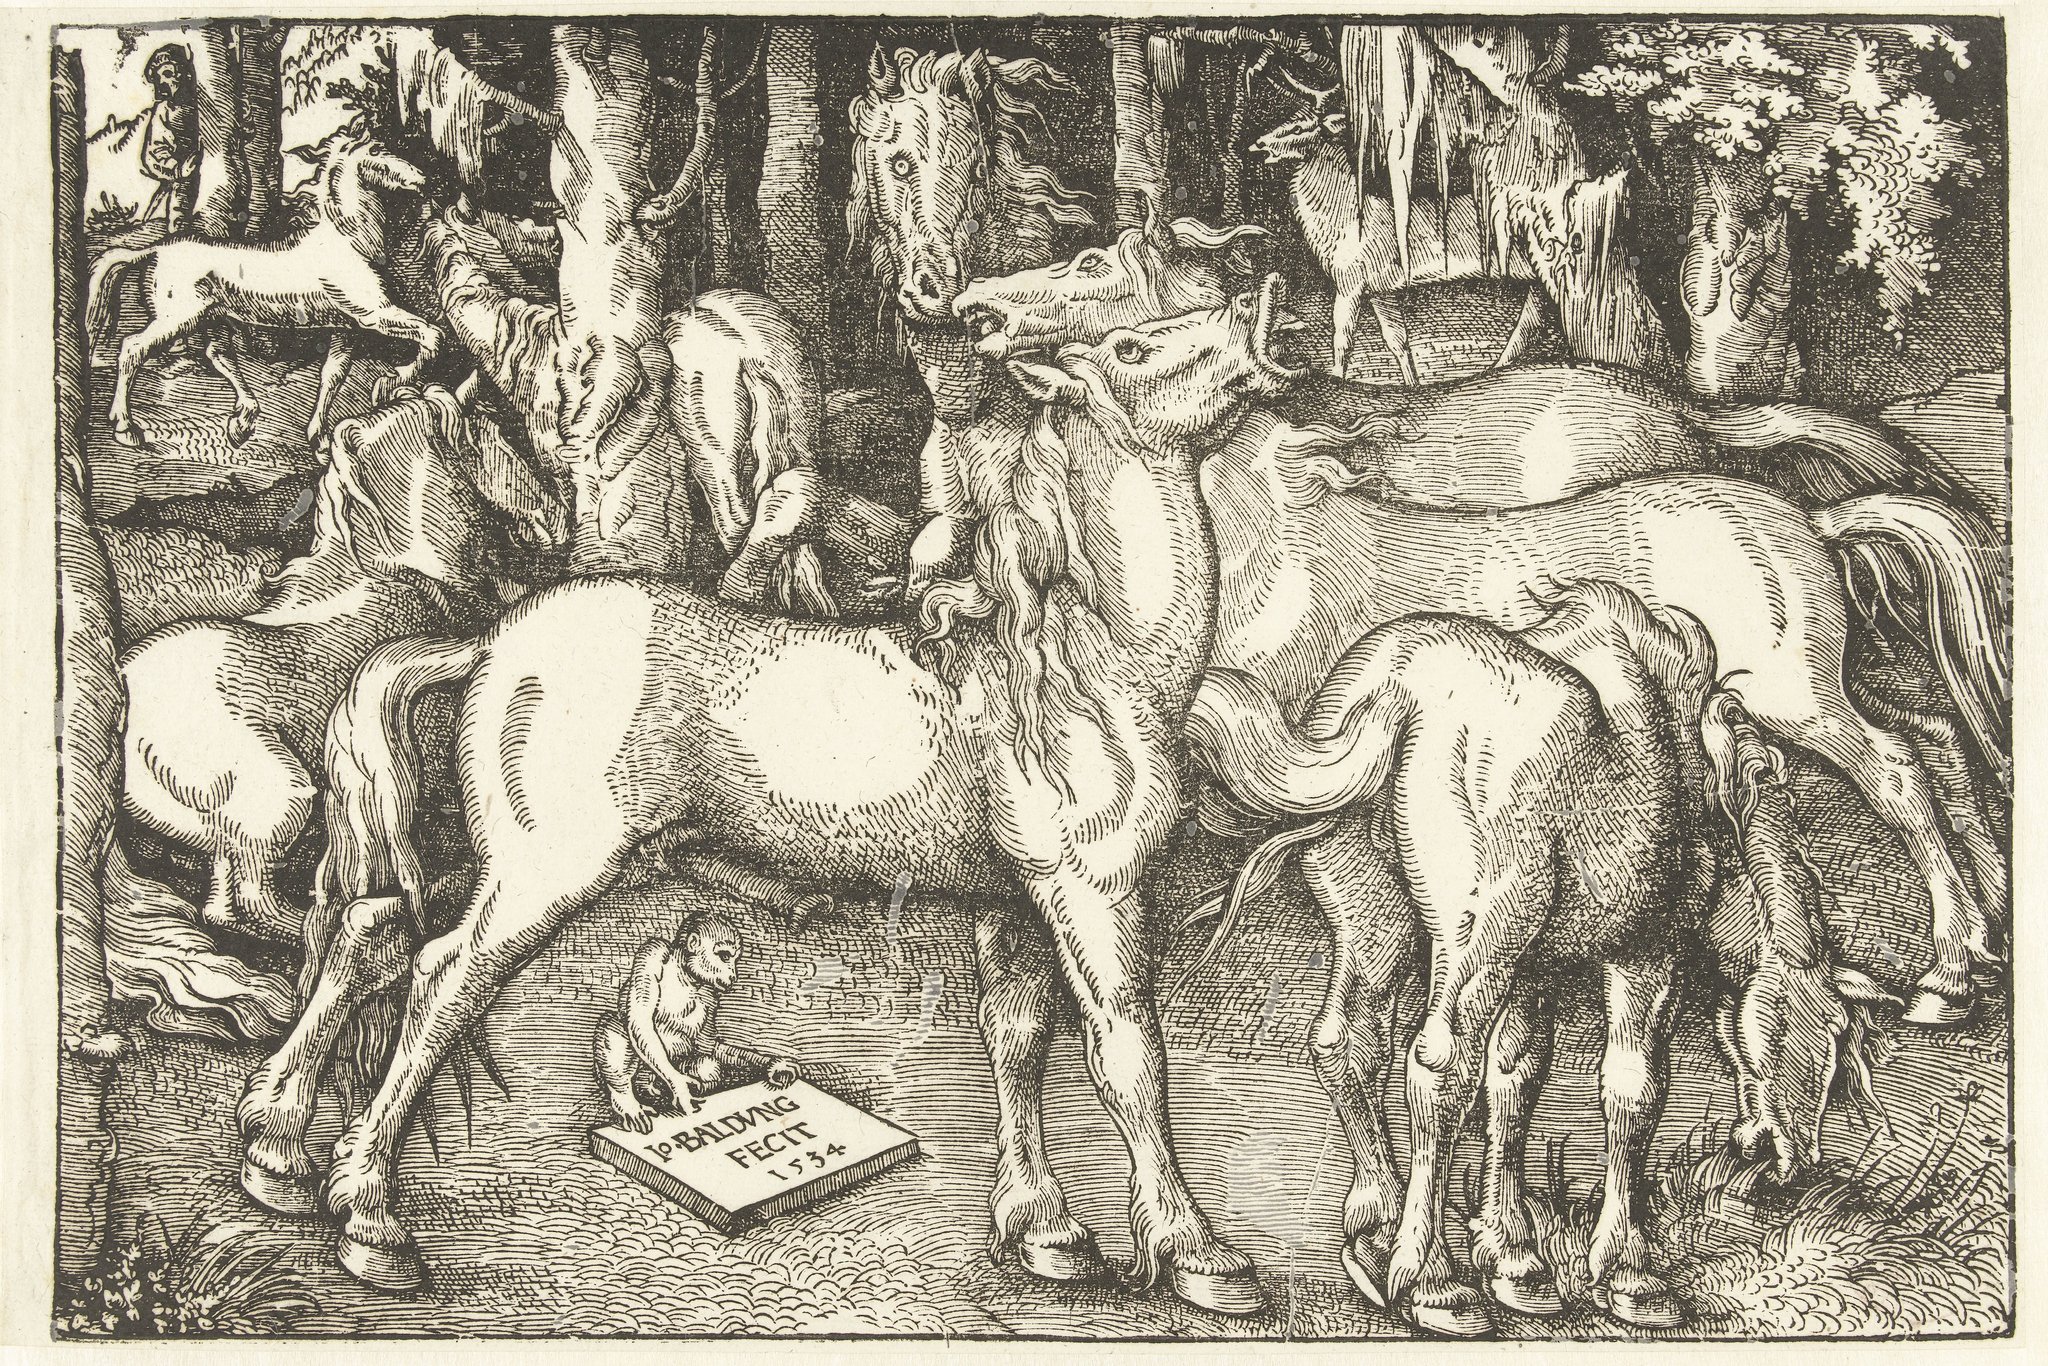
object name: print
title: Groep van zeven paarden en een aap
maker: hans baldung grien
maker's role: draughtsman, print maker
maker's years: 1484-1545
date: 1534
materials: paper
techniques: woodcut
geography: straatsburg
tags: monkeys, apes, fighting horses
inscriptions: collector's mark: Lugt 240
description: In een bos staat een groep paarden met op de voorgrond een briesende hengst en een grazend paard. De andere bewegen zich onrustig met wapperende manen en opengesperde neusgaten en ogen. Een aap houdt een schild met het signatuur en datering vast. Op de achtergrond staat een hert en links verschuilt een man zich achter een boom.